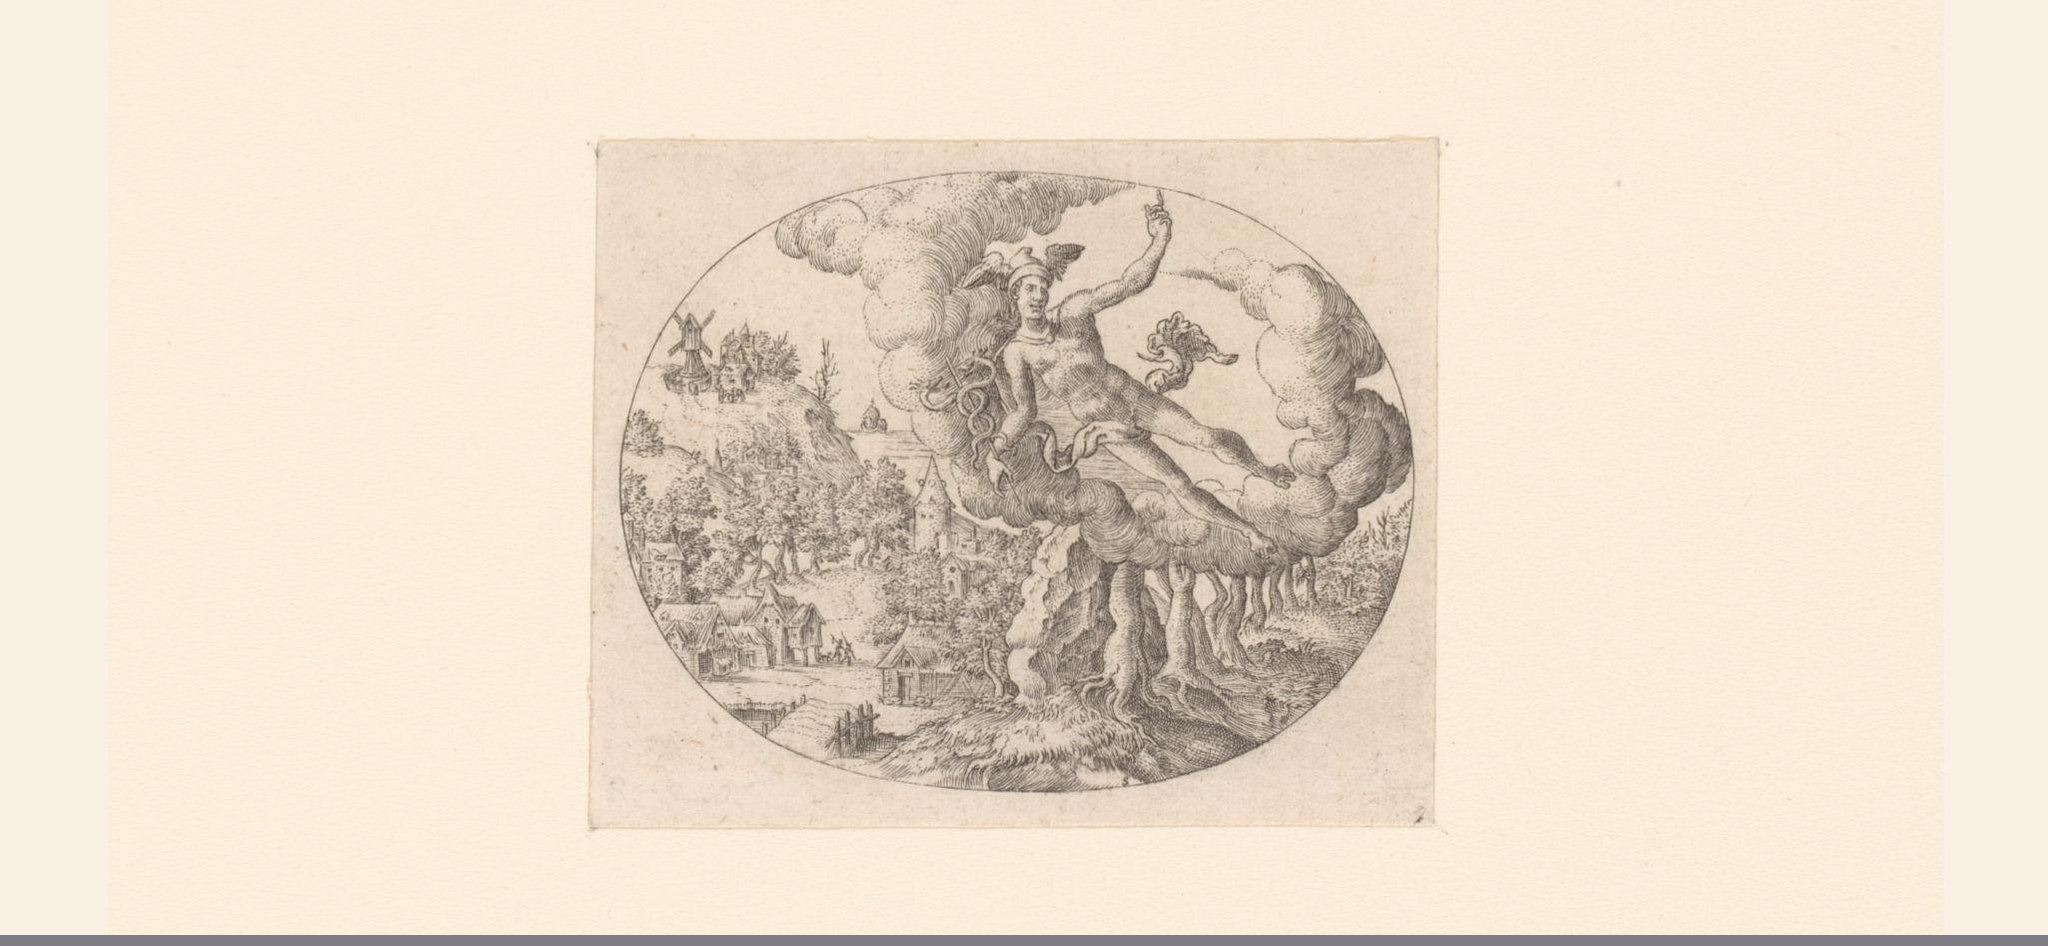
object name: print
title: De vier elementen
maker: etienne delaune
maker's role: draughtsman, goldsmith, print maker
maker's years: 1519-1583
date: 1573-1580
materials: paper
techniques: engraving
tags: the four elements, and ether, the fifth element, (story of) mercury (hermes), air (one of the four elements)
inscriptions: collector's mark: Lugt 2228, collector's mark: Lugt 2760, collector's mark: Lugt 1041c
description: Maakt deel uit van een vierdelige serie met personificaties van de vier elementen als klassieke goden in ovale vorm.